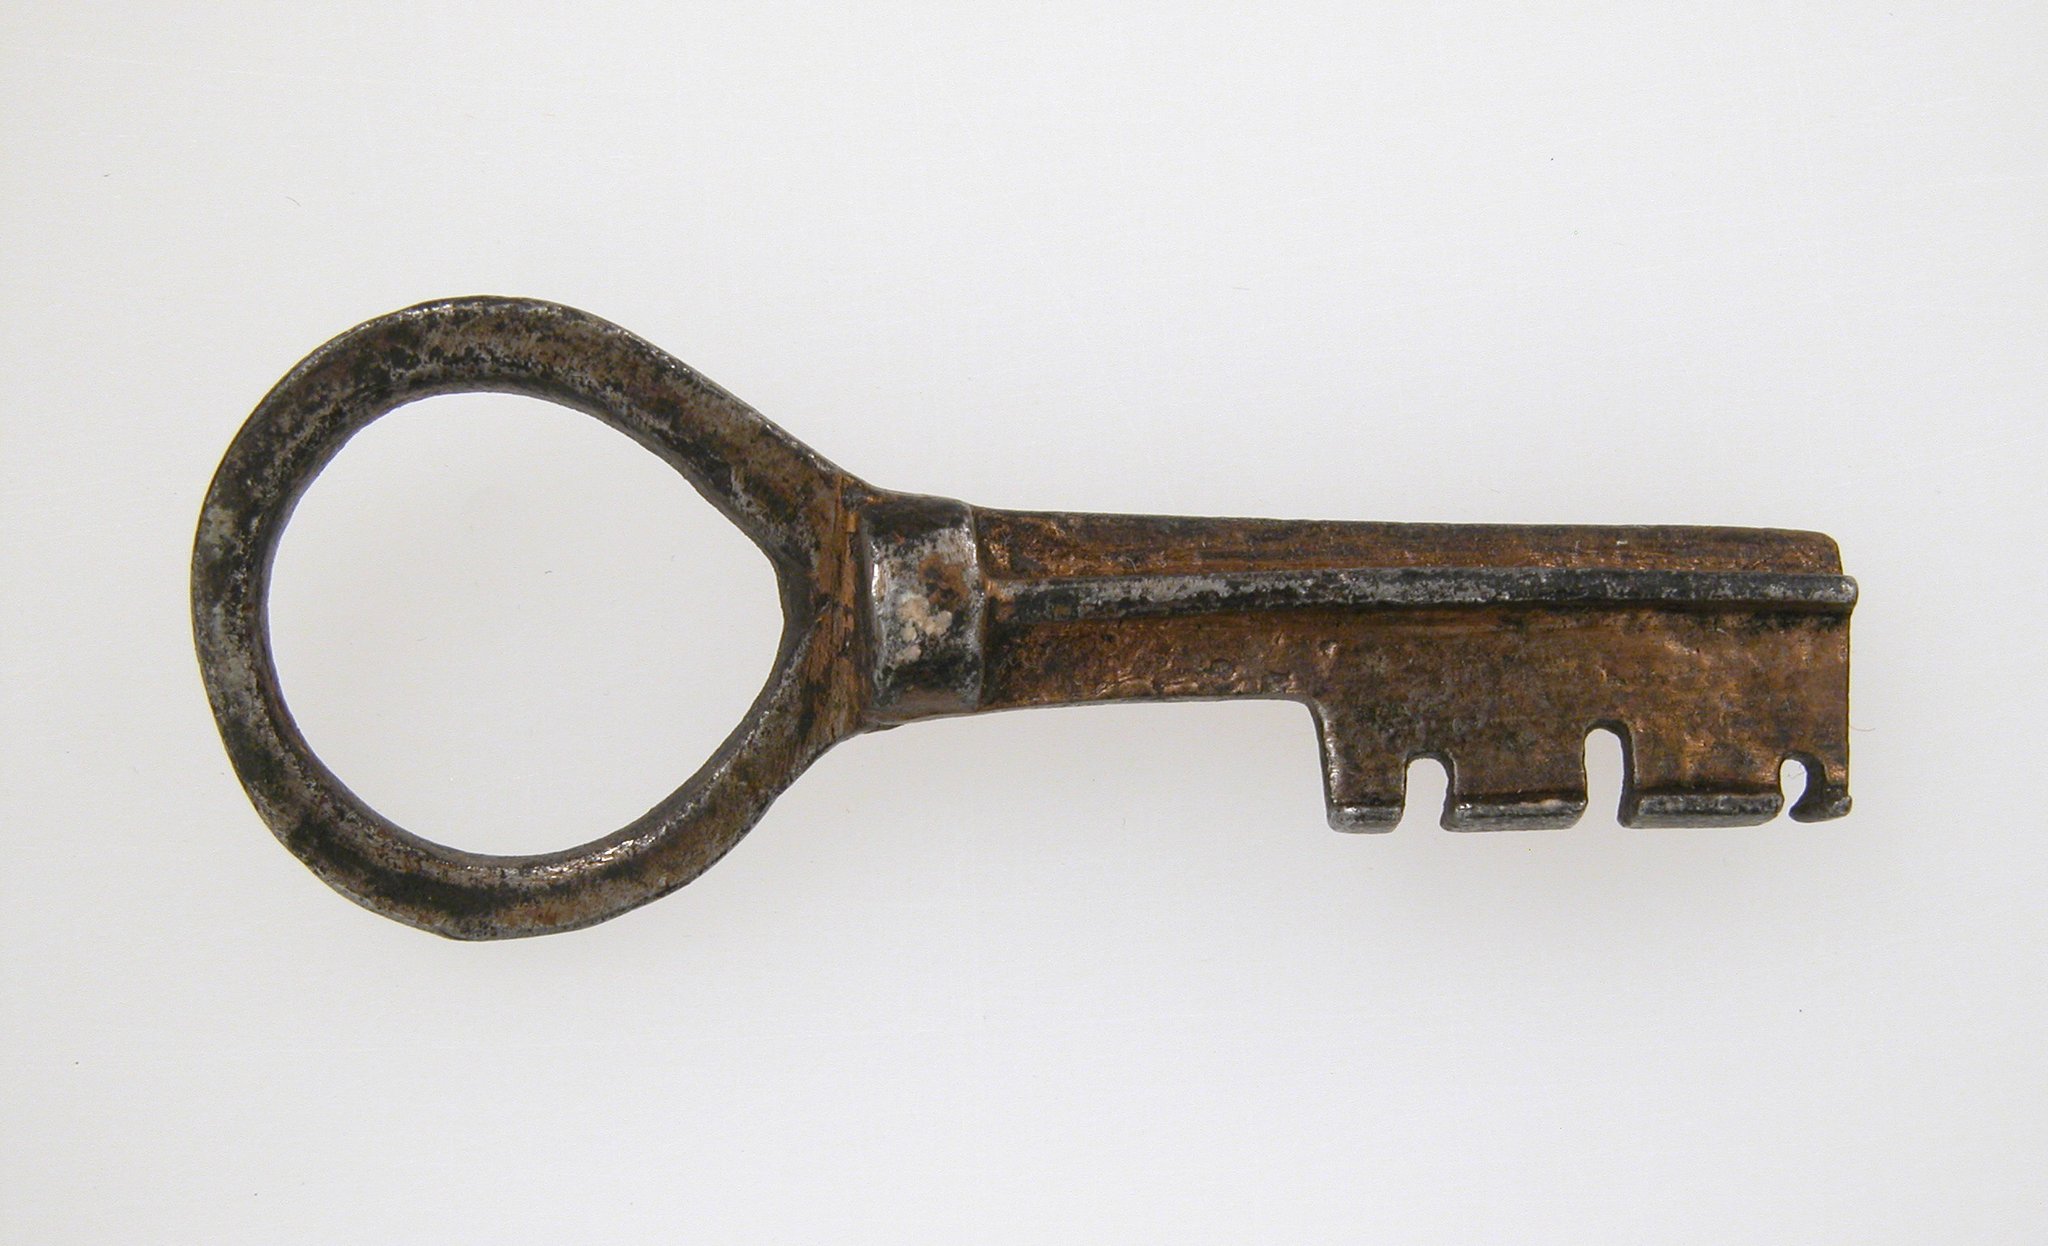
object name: key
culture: german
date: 1301-1400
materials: iron